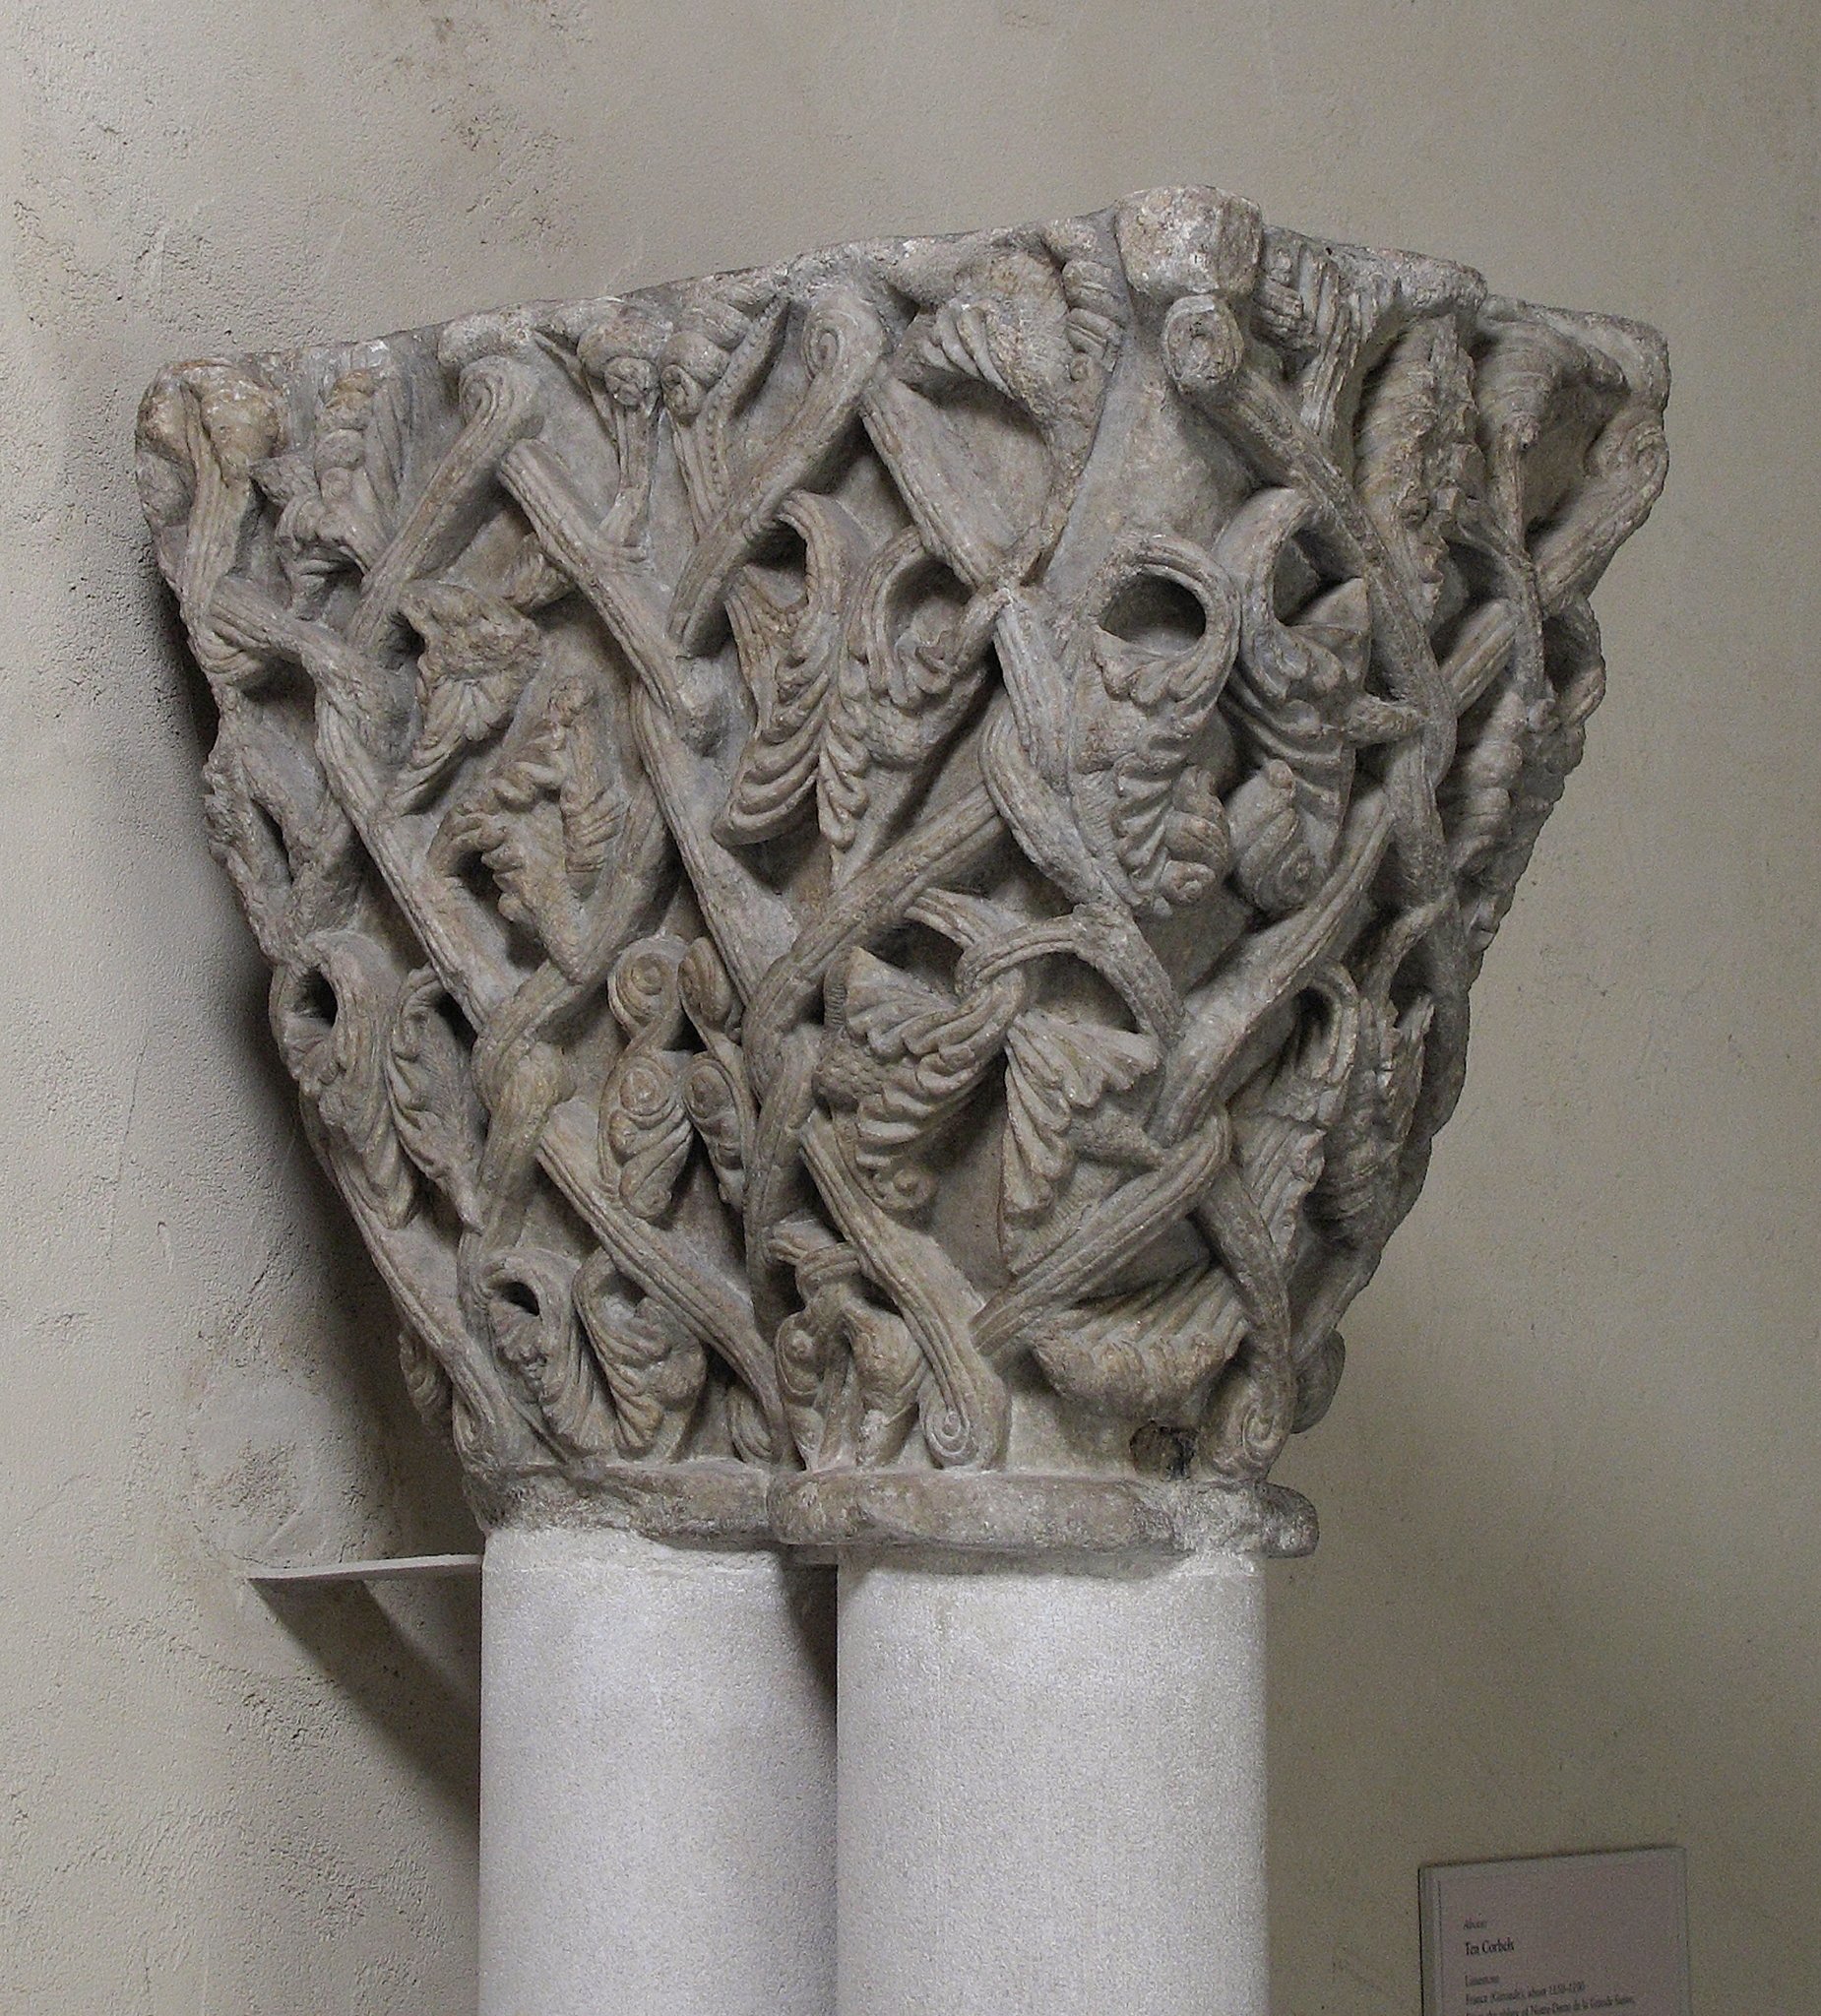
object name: capital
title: Double Capital with Vine Tendrils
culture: french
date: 1170-1180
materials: marble